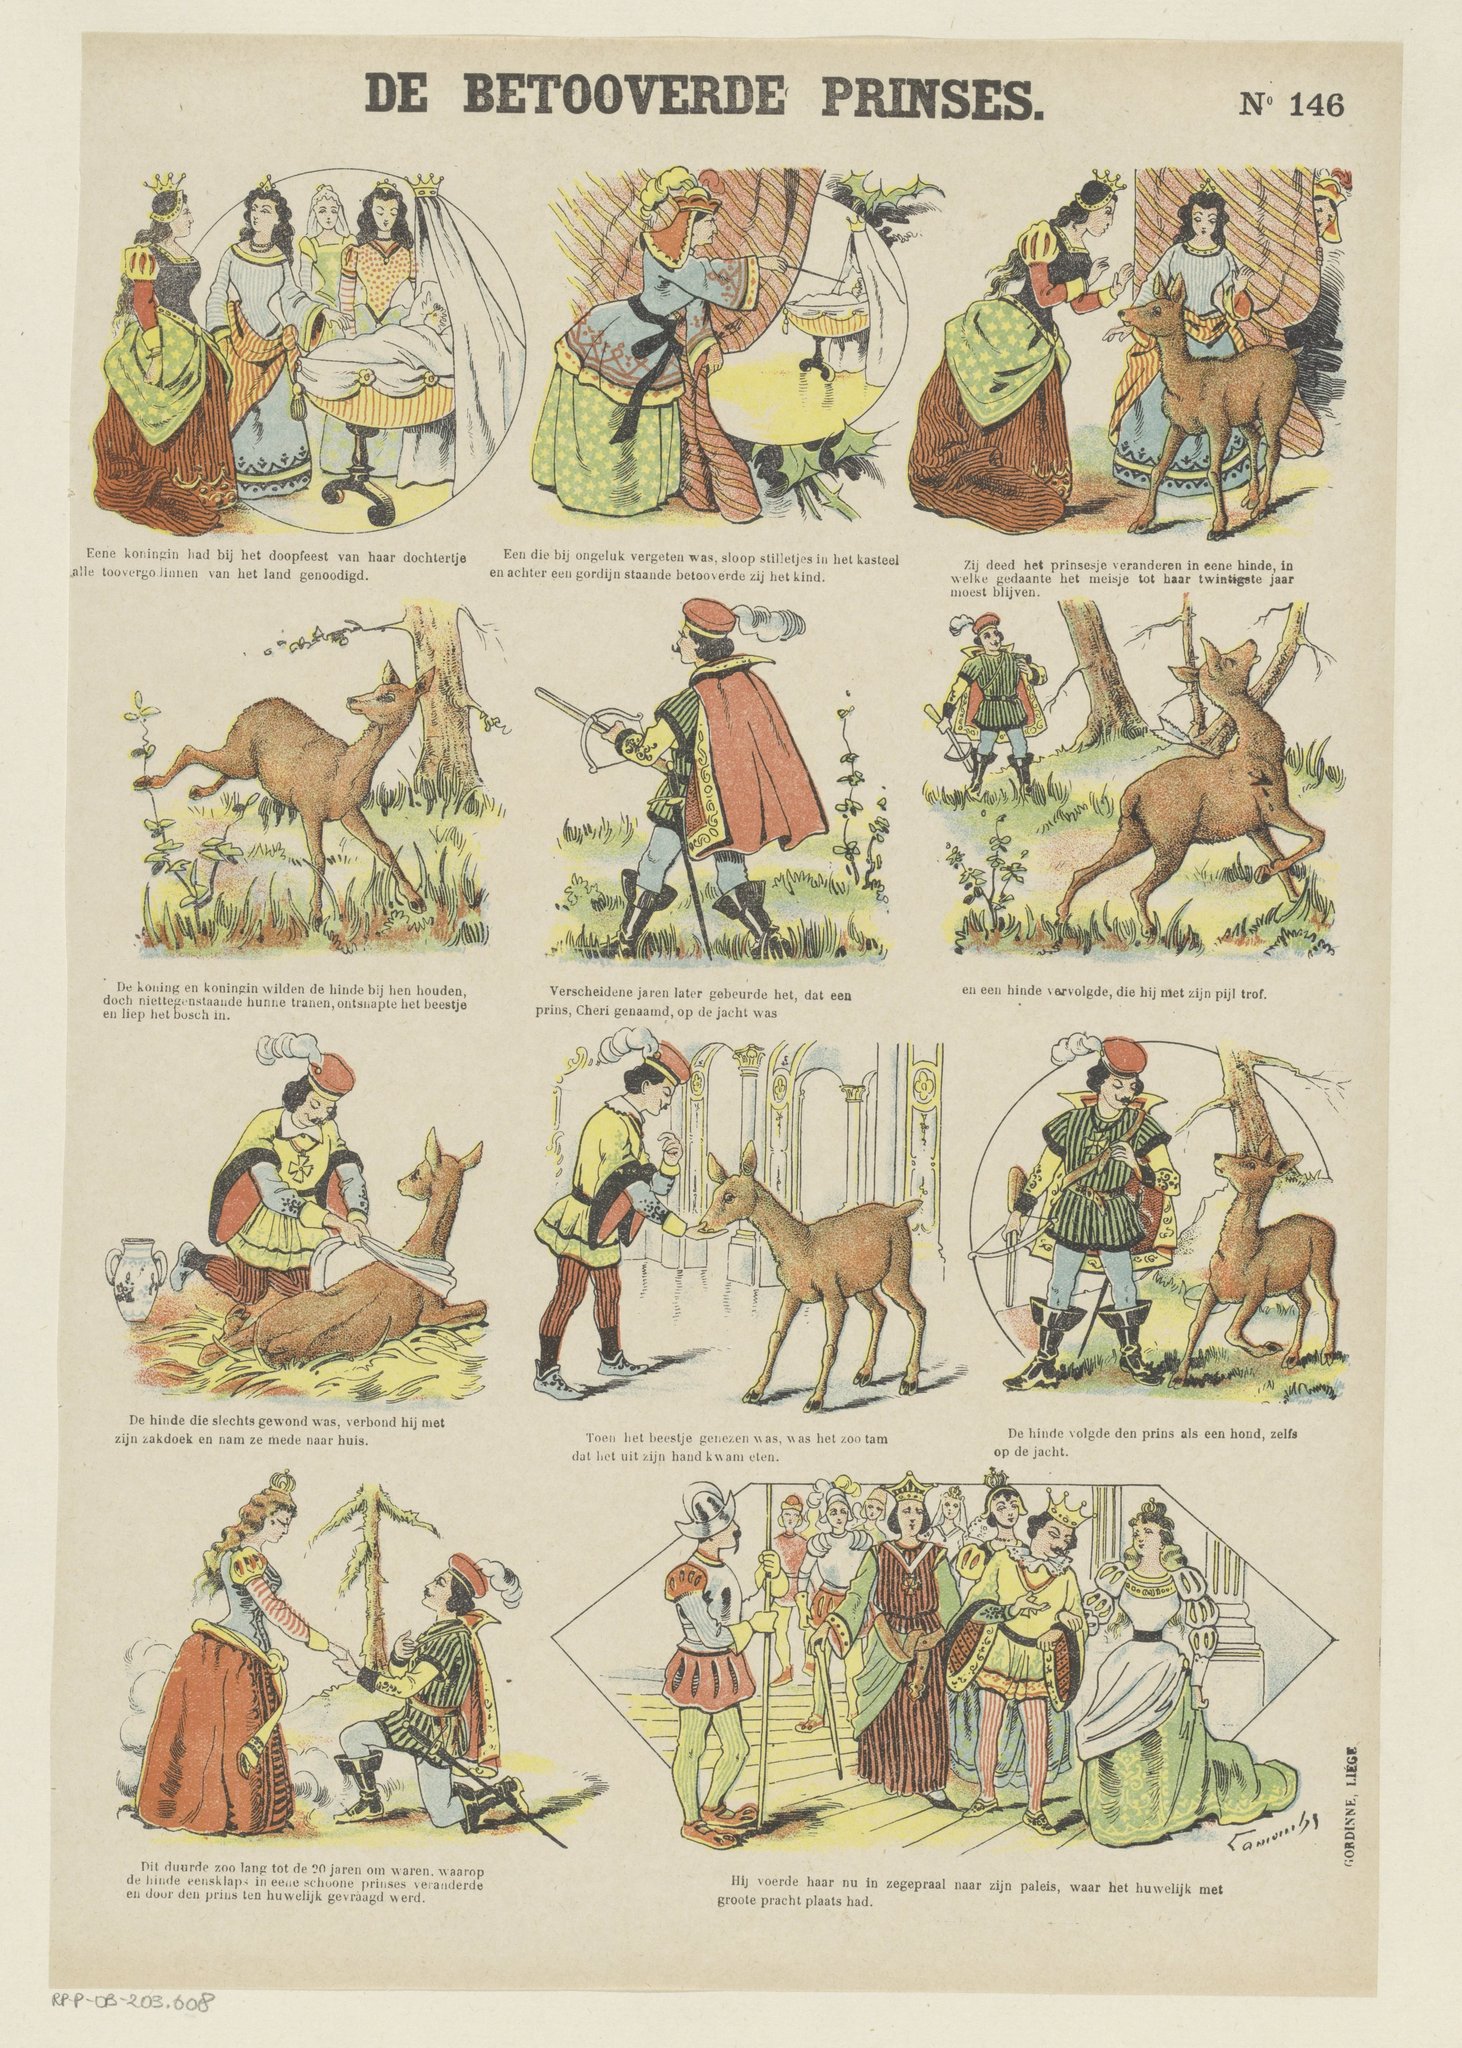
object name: print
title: De betooverde prinses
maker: lamouche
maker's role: print maker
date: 1894-1959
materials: paper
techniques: lithograph, letterpress printing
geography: liège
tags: princess, tales and fairy tales, metamorphosed human beings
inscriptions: collector's mark: Lugt 2760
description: Blad met 11 voorstellingen over een betoverde prinses. Onder elke afbeelding een onderschrift. Genummerd rechtsboven: No 146.